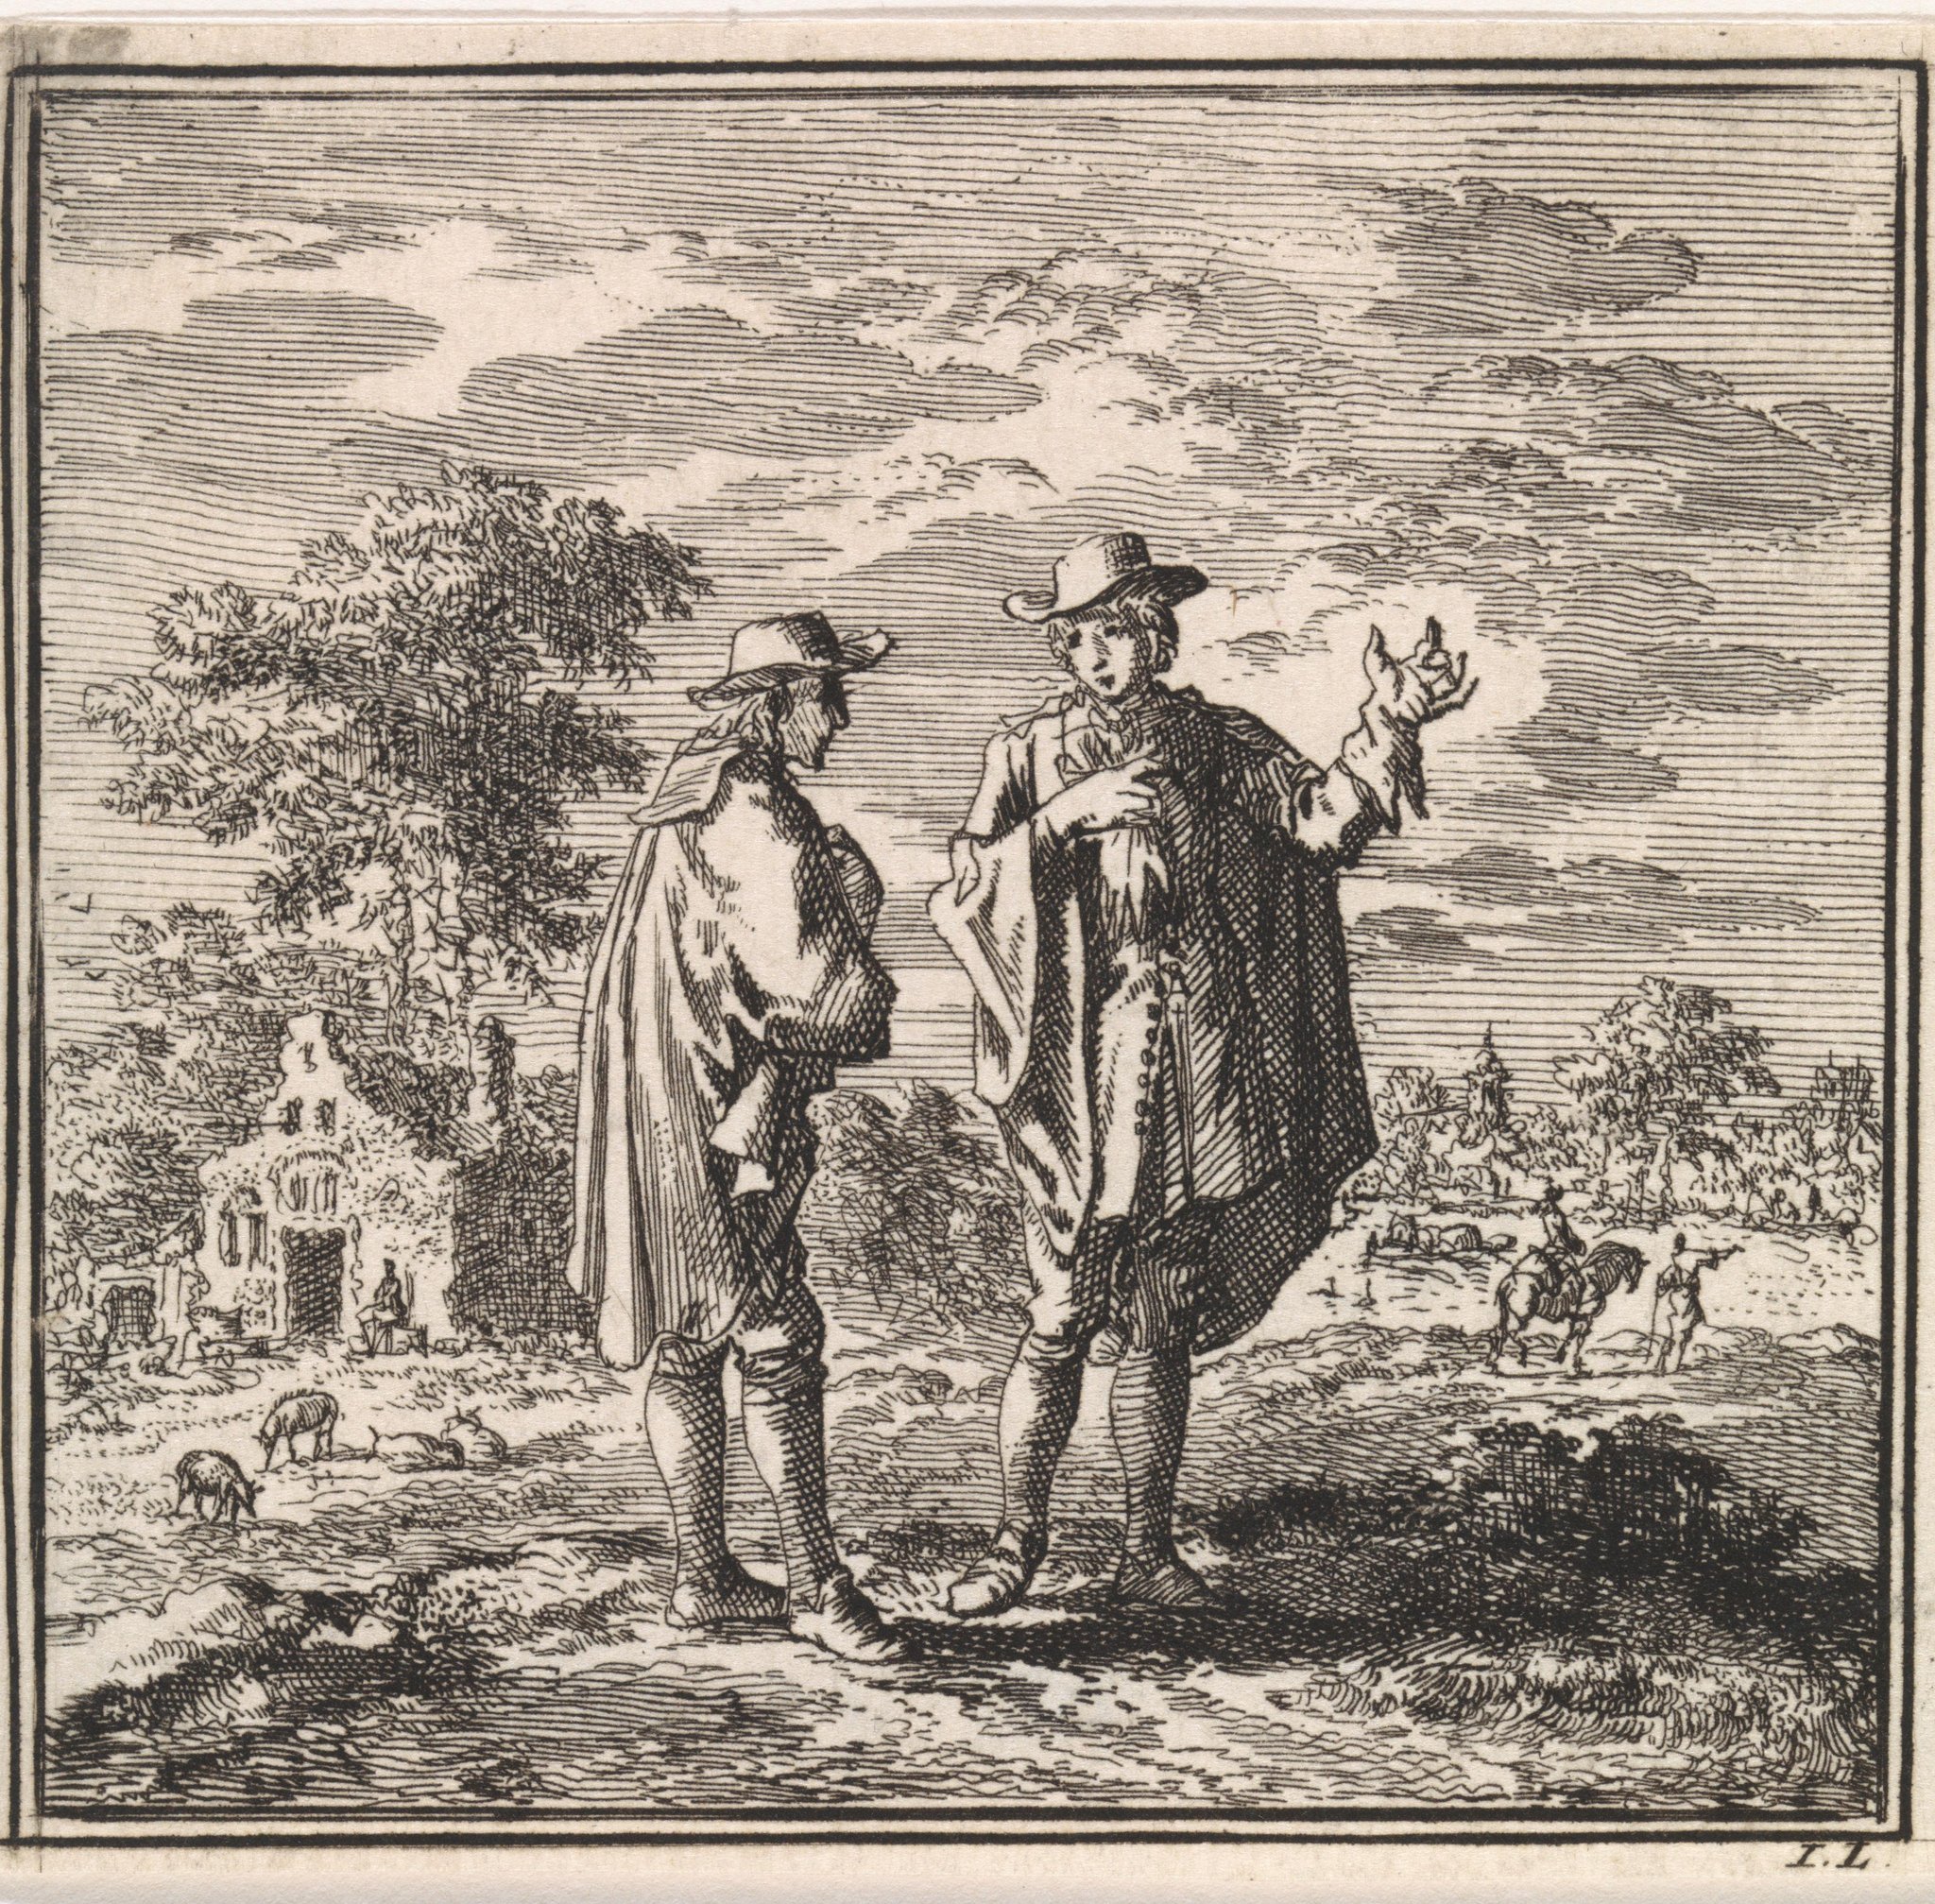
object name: book illustration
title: Man toont zijn hand met handschoen aan een metgezel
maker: jan luyken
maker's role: draughtsman, print maker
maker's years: 1649-1712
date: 1711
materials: paper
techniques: etching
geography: amsterdam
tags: gloves, mittens, etc.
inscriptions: collector's mark: Lugt 2228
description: Illustratie voor: Luyken, Jan. De Bykorf des Gemoeds. Amsterdam: Pieter Arentsz. II (wed.) en Cornelis van der Sys, 1711, p. 170.